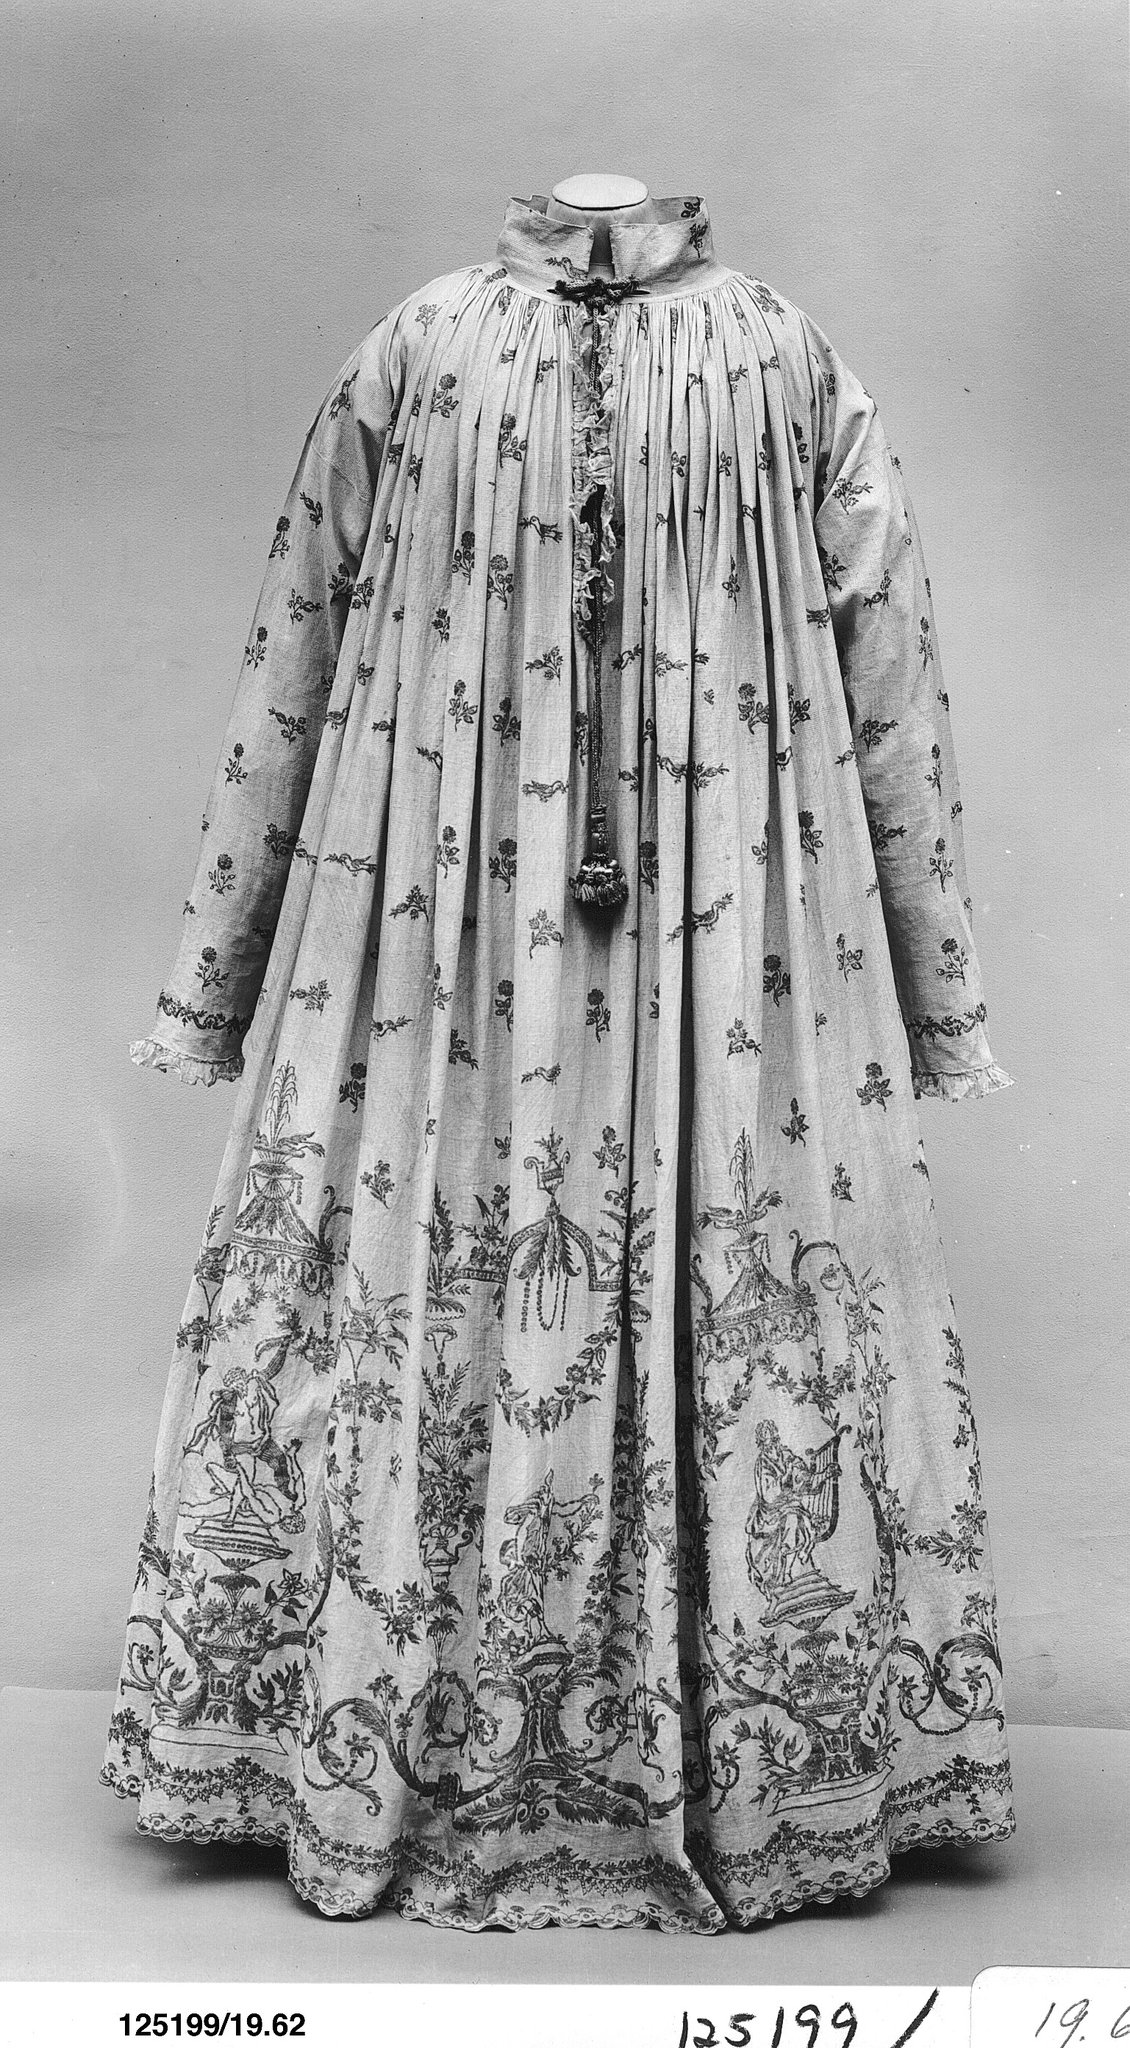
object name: alb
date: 1767-1800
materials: linen, metal thread, silk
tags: birds,harps